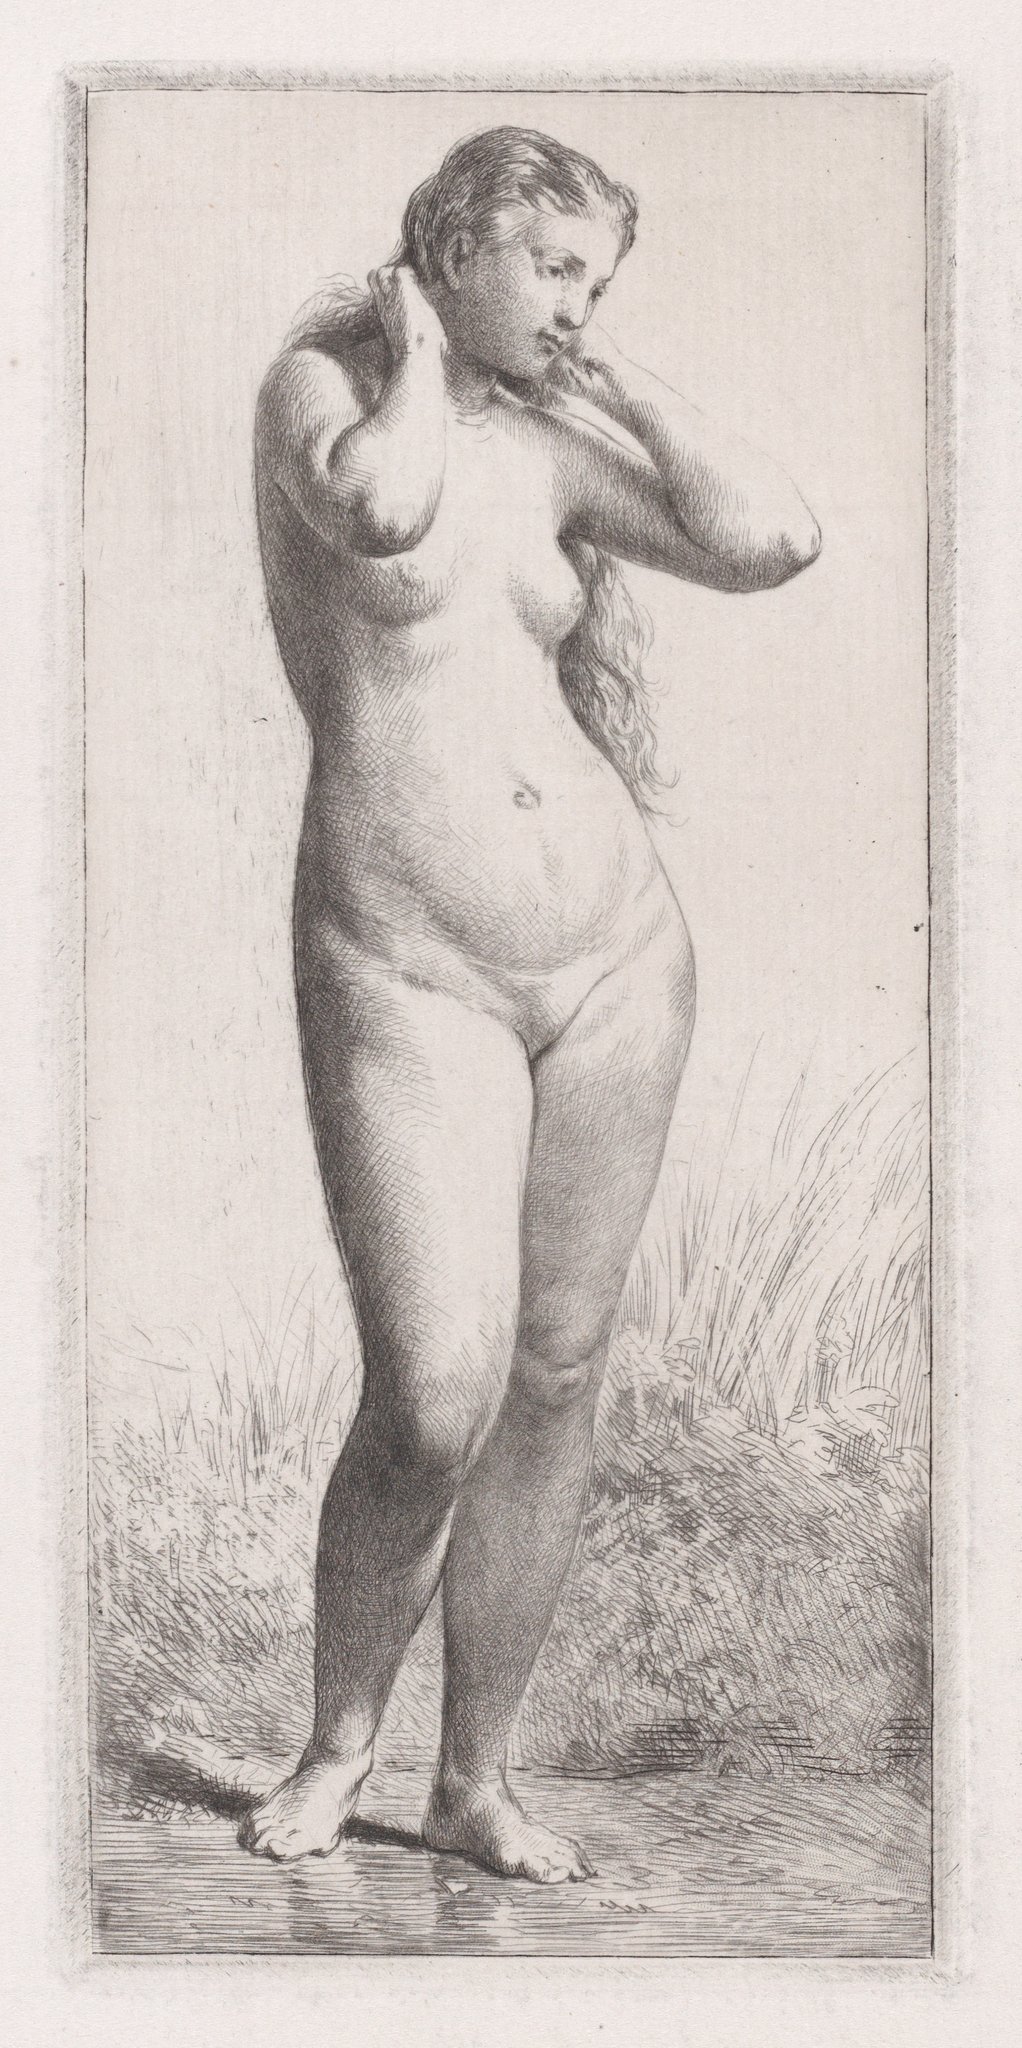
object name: print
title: Jeune Femme au Bain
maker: charles émile jacque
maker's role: artist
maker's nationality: french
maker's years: 1813-1894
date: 1866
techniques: etching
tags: women,female nudes